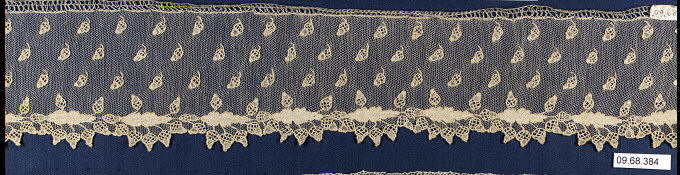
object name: fragment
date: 1801-1900